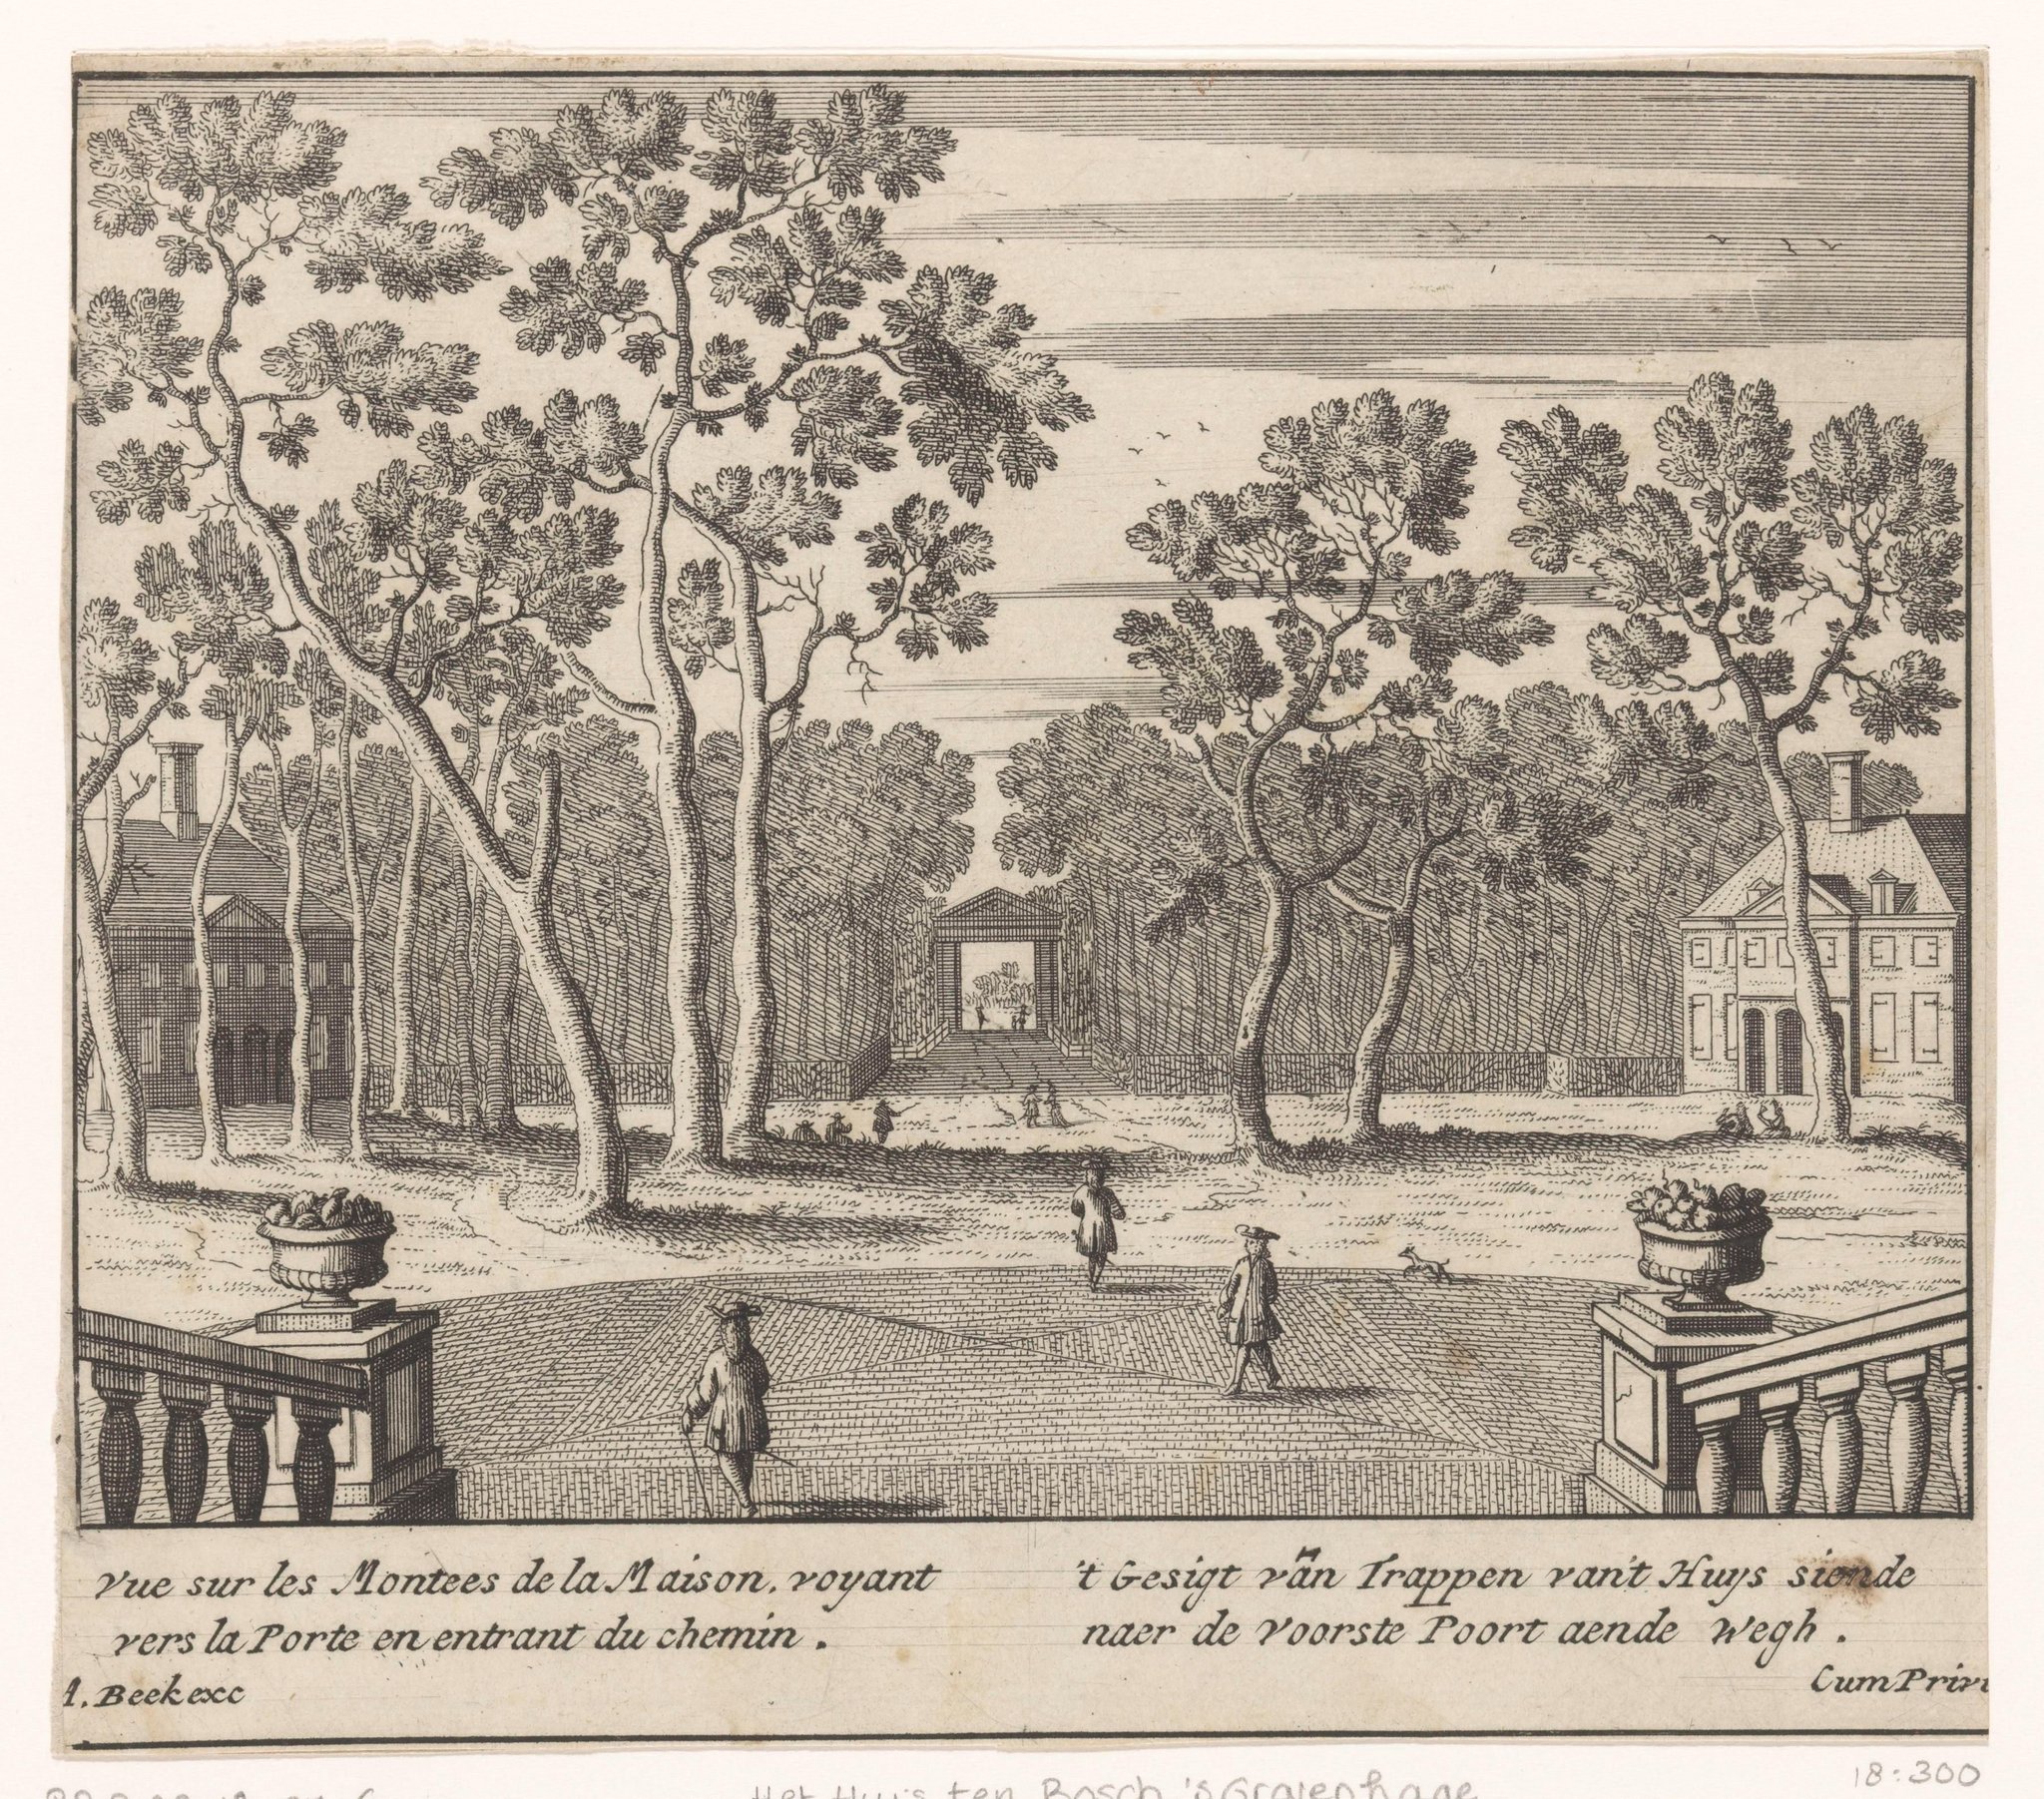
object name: print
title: Gezicht op de voorste poort van Huis ten Bosch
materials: paper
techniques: engraving, etching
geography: the hague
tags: palace, gate, entrance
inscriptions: collector's mark: Lugt 2228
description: Mogelijk uitgegeven als onderdeel van een serie van zestien prenten en een panorama van Huis ten Bosch. Zie ook RP-P-AO-12-97-1, RP-P-AO-12-97-2, RP-P-AO-12-97-3, RP-P-AO-12-97-4, RP-P-AO-12-97-5, RP-P-AO-12-97-7, RP-P-AO-12-97-8, RP-P-AO-12-97-9, RP-P-AO-12-97-10, RP-P-AO-12-97-11, RP-P-AO-12-97-12, RP-P-AO-12-97-13, RP-P-AO-12-97-14 en RP-P-AO-12-97-15.